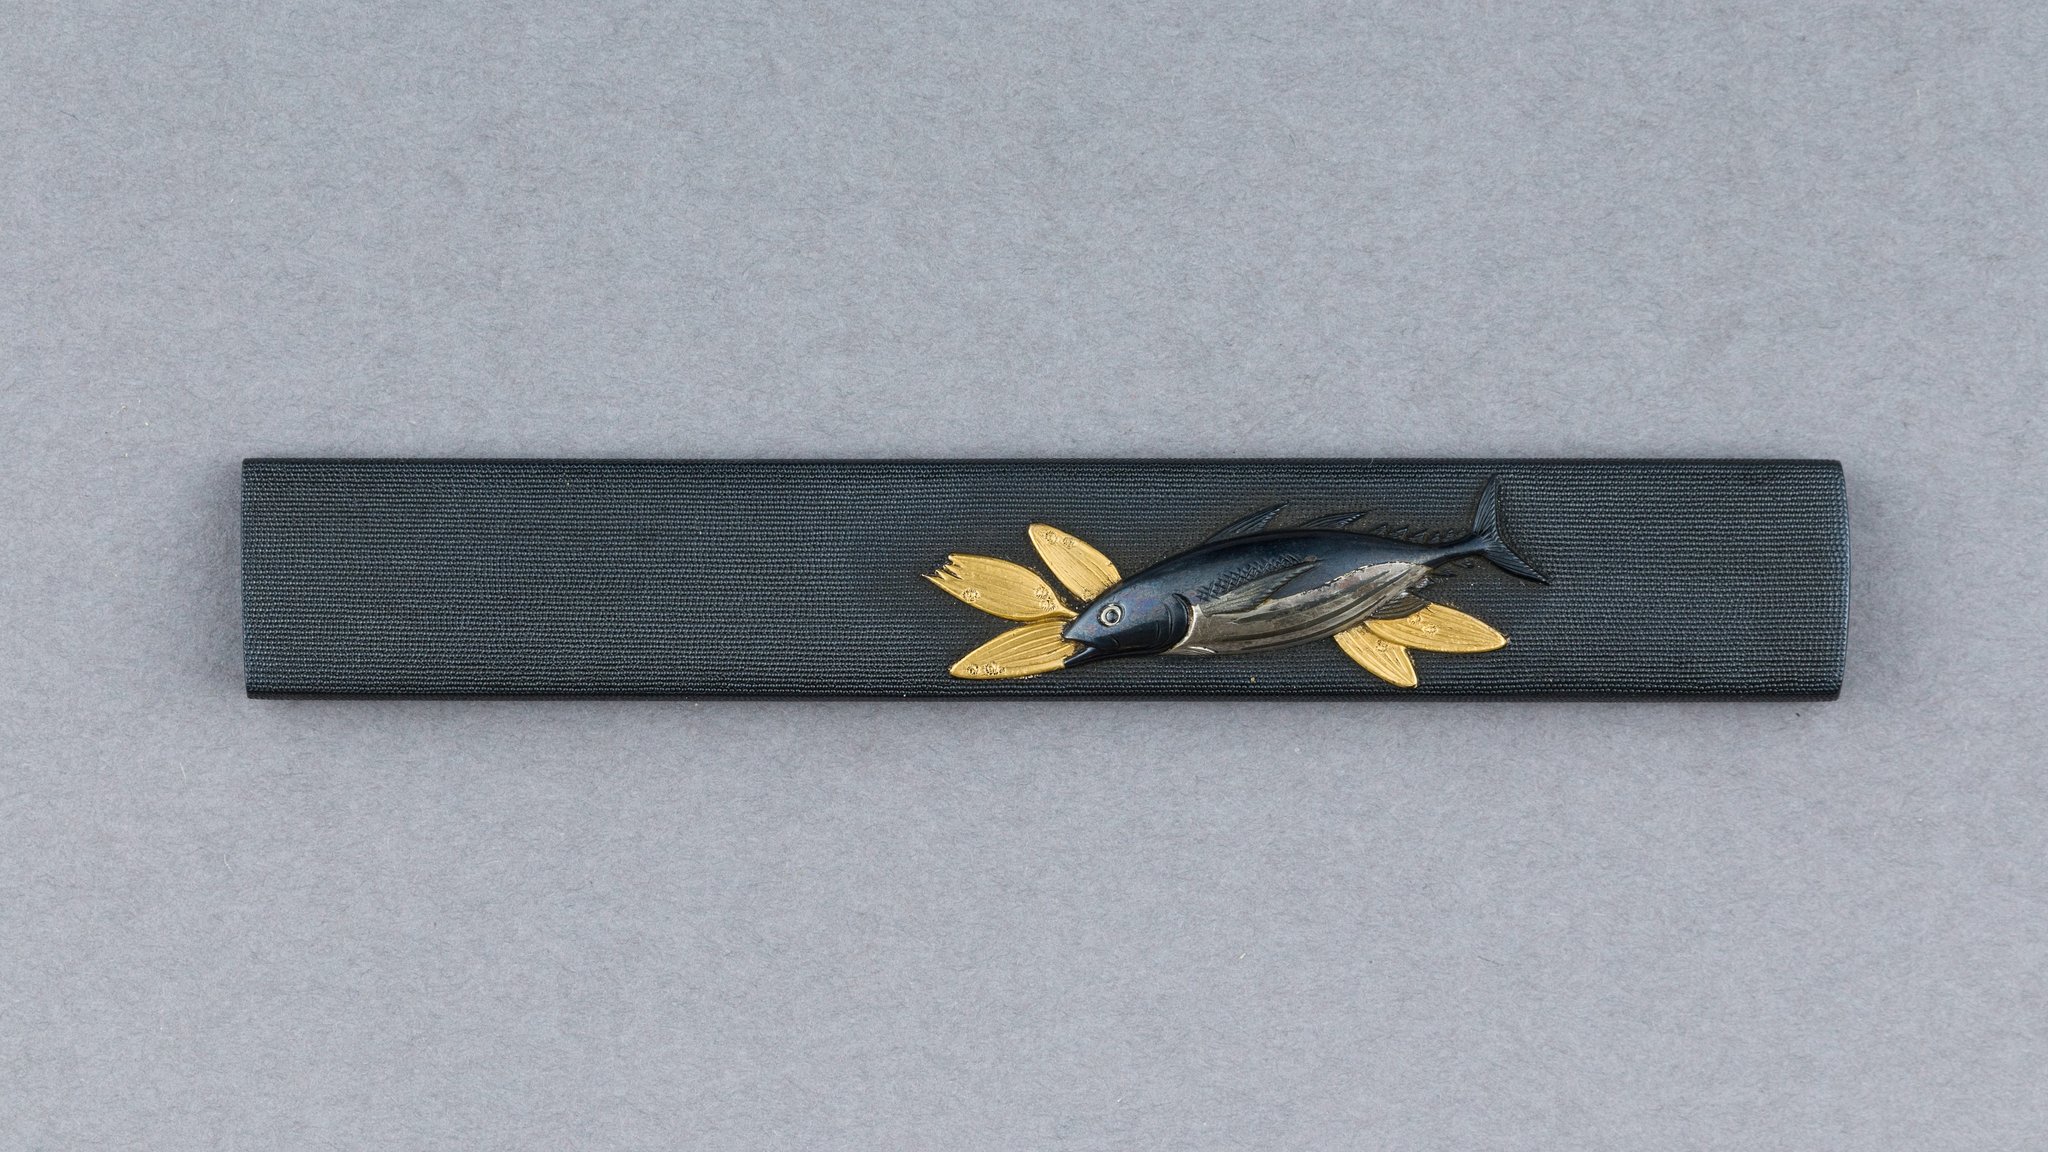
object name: knife handle kozuka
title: Knife Handle (Kozuka)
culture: japanese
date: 1615-1868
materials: gold alloy, gold, silver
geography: japan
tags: fish